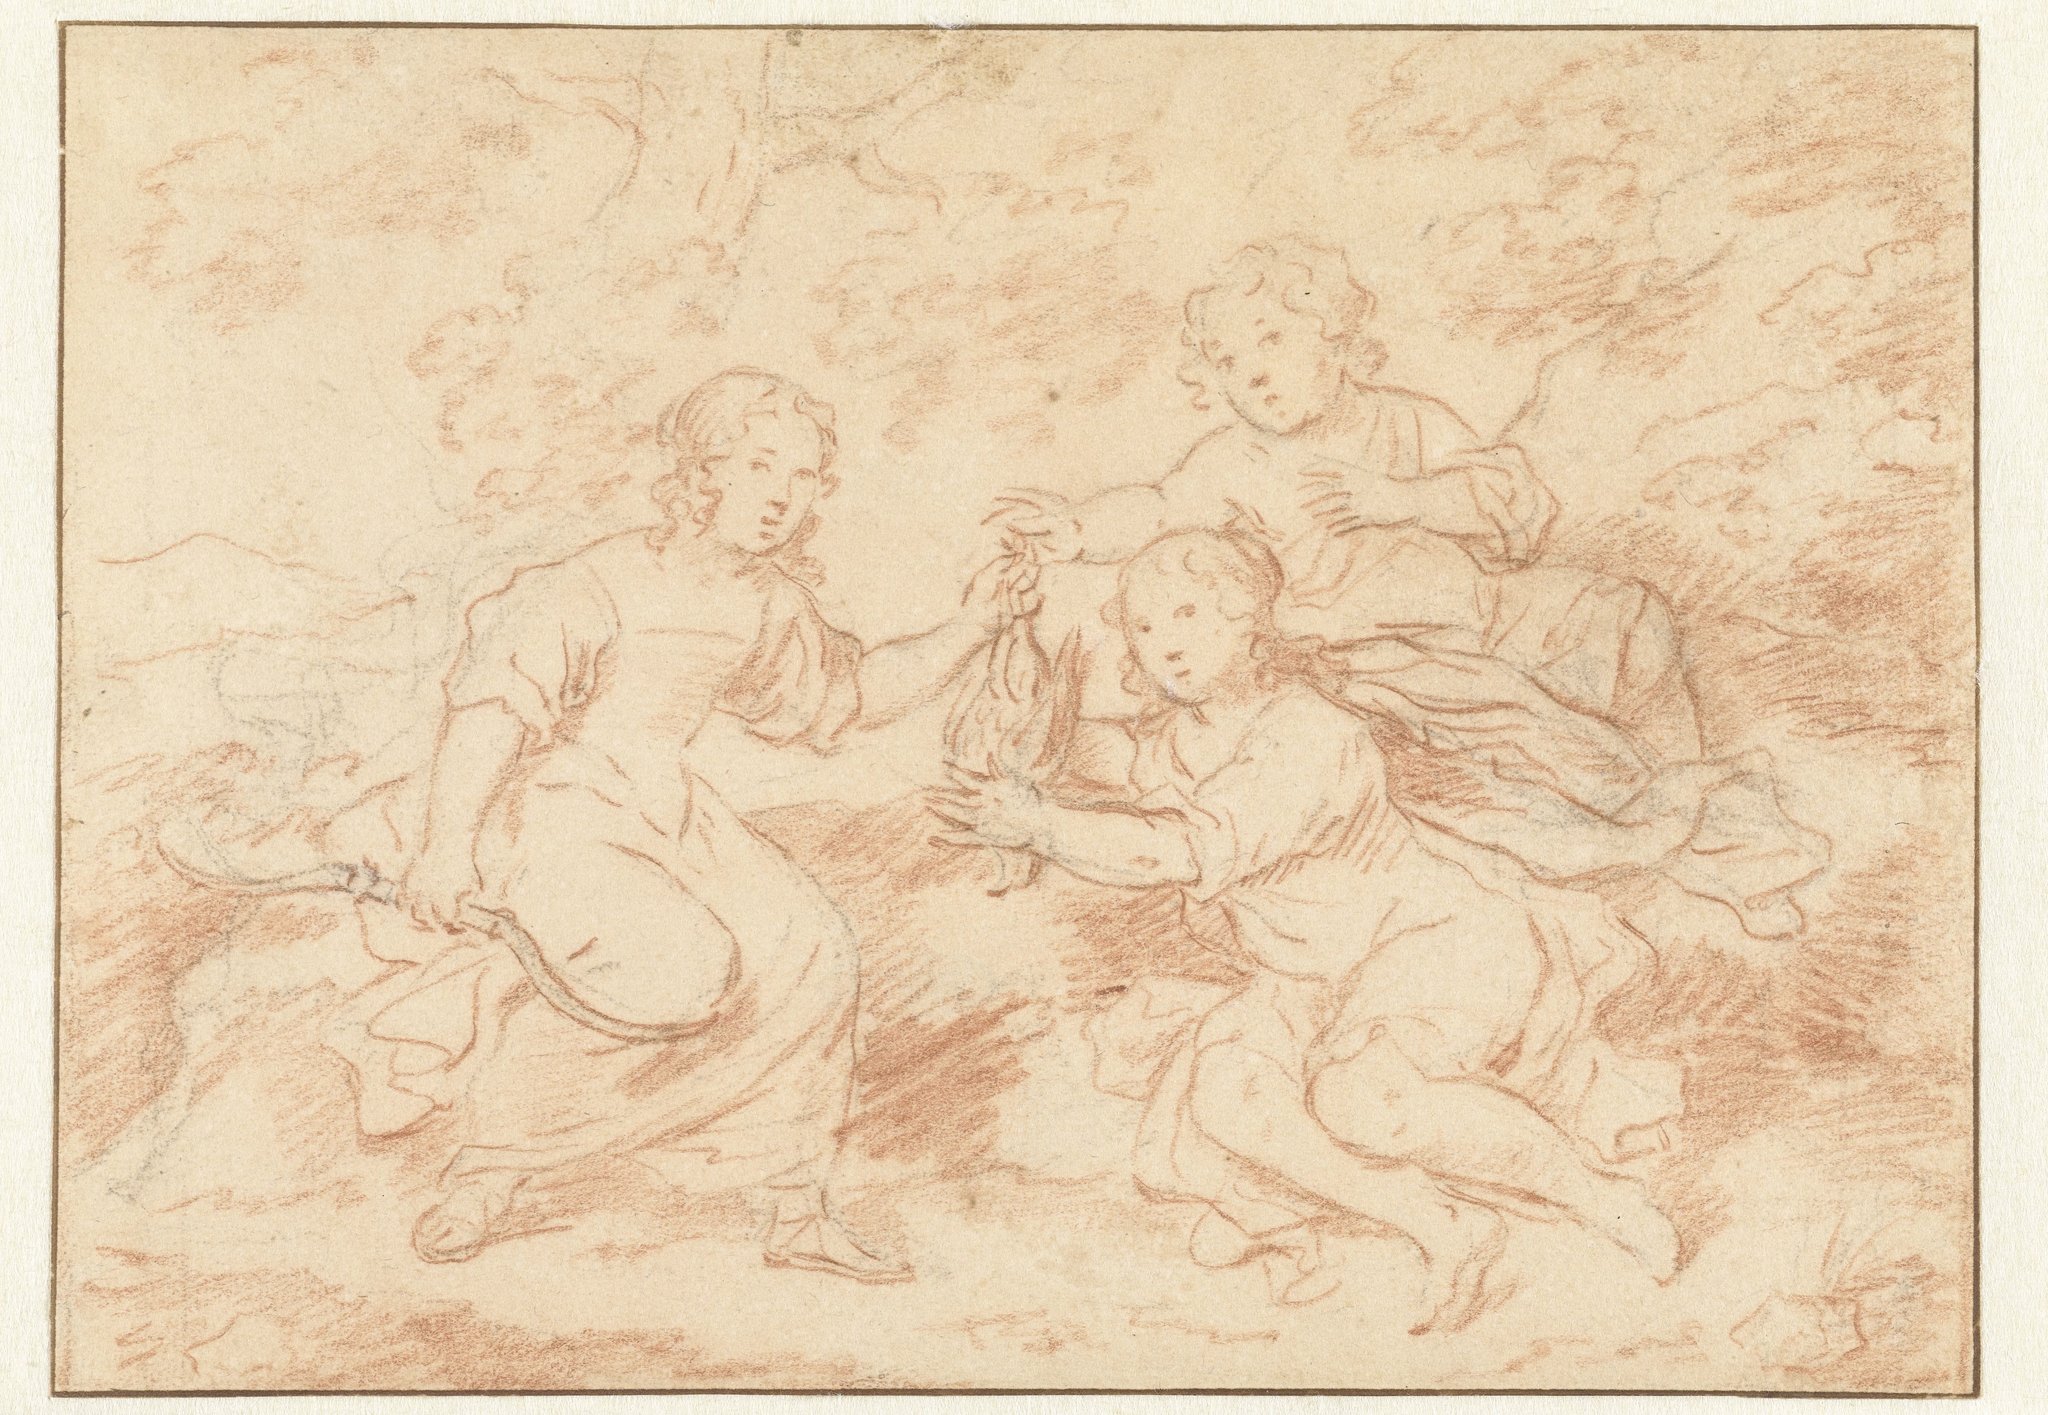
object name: drawing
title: Drie kinderen in een landschap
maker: caspar netscher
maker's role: draughtsman, painter, print maker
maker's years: 1639-1684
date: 1649-1684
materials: chalk, paper, pencil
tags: hunter displaying or presenting the spoils of the hunt, boy (child between toddler and youth), girl (child between toddler and youth), bird hunting (+ bow and arrow)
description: Drie kinderen in een landschap, met pijl en boog en een dode vogel.